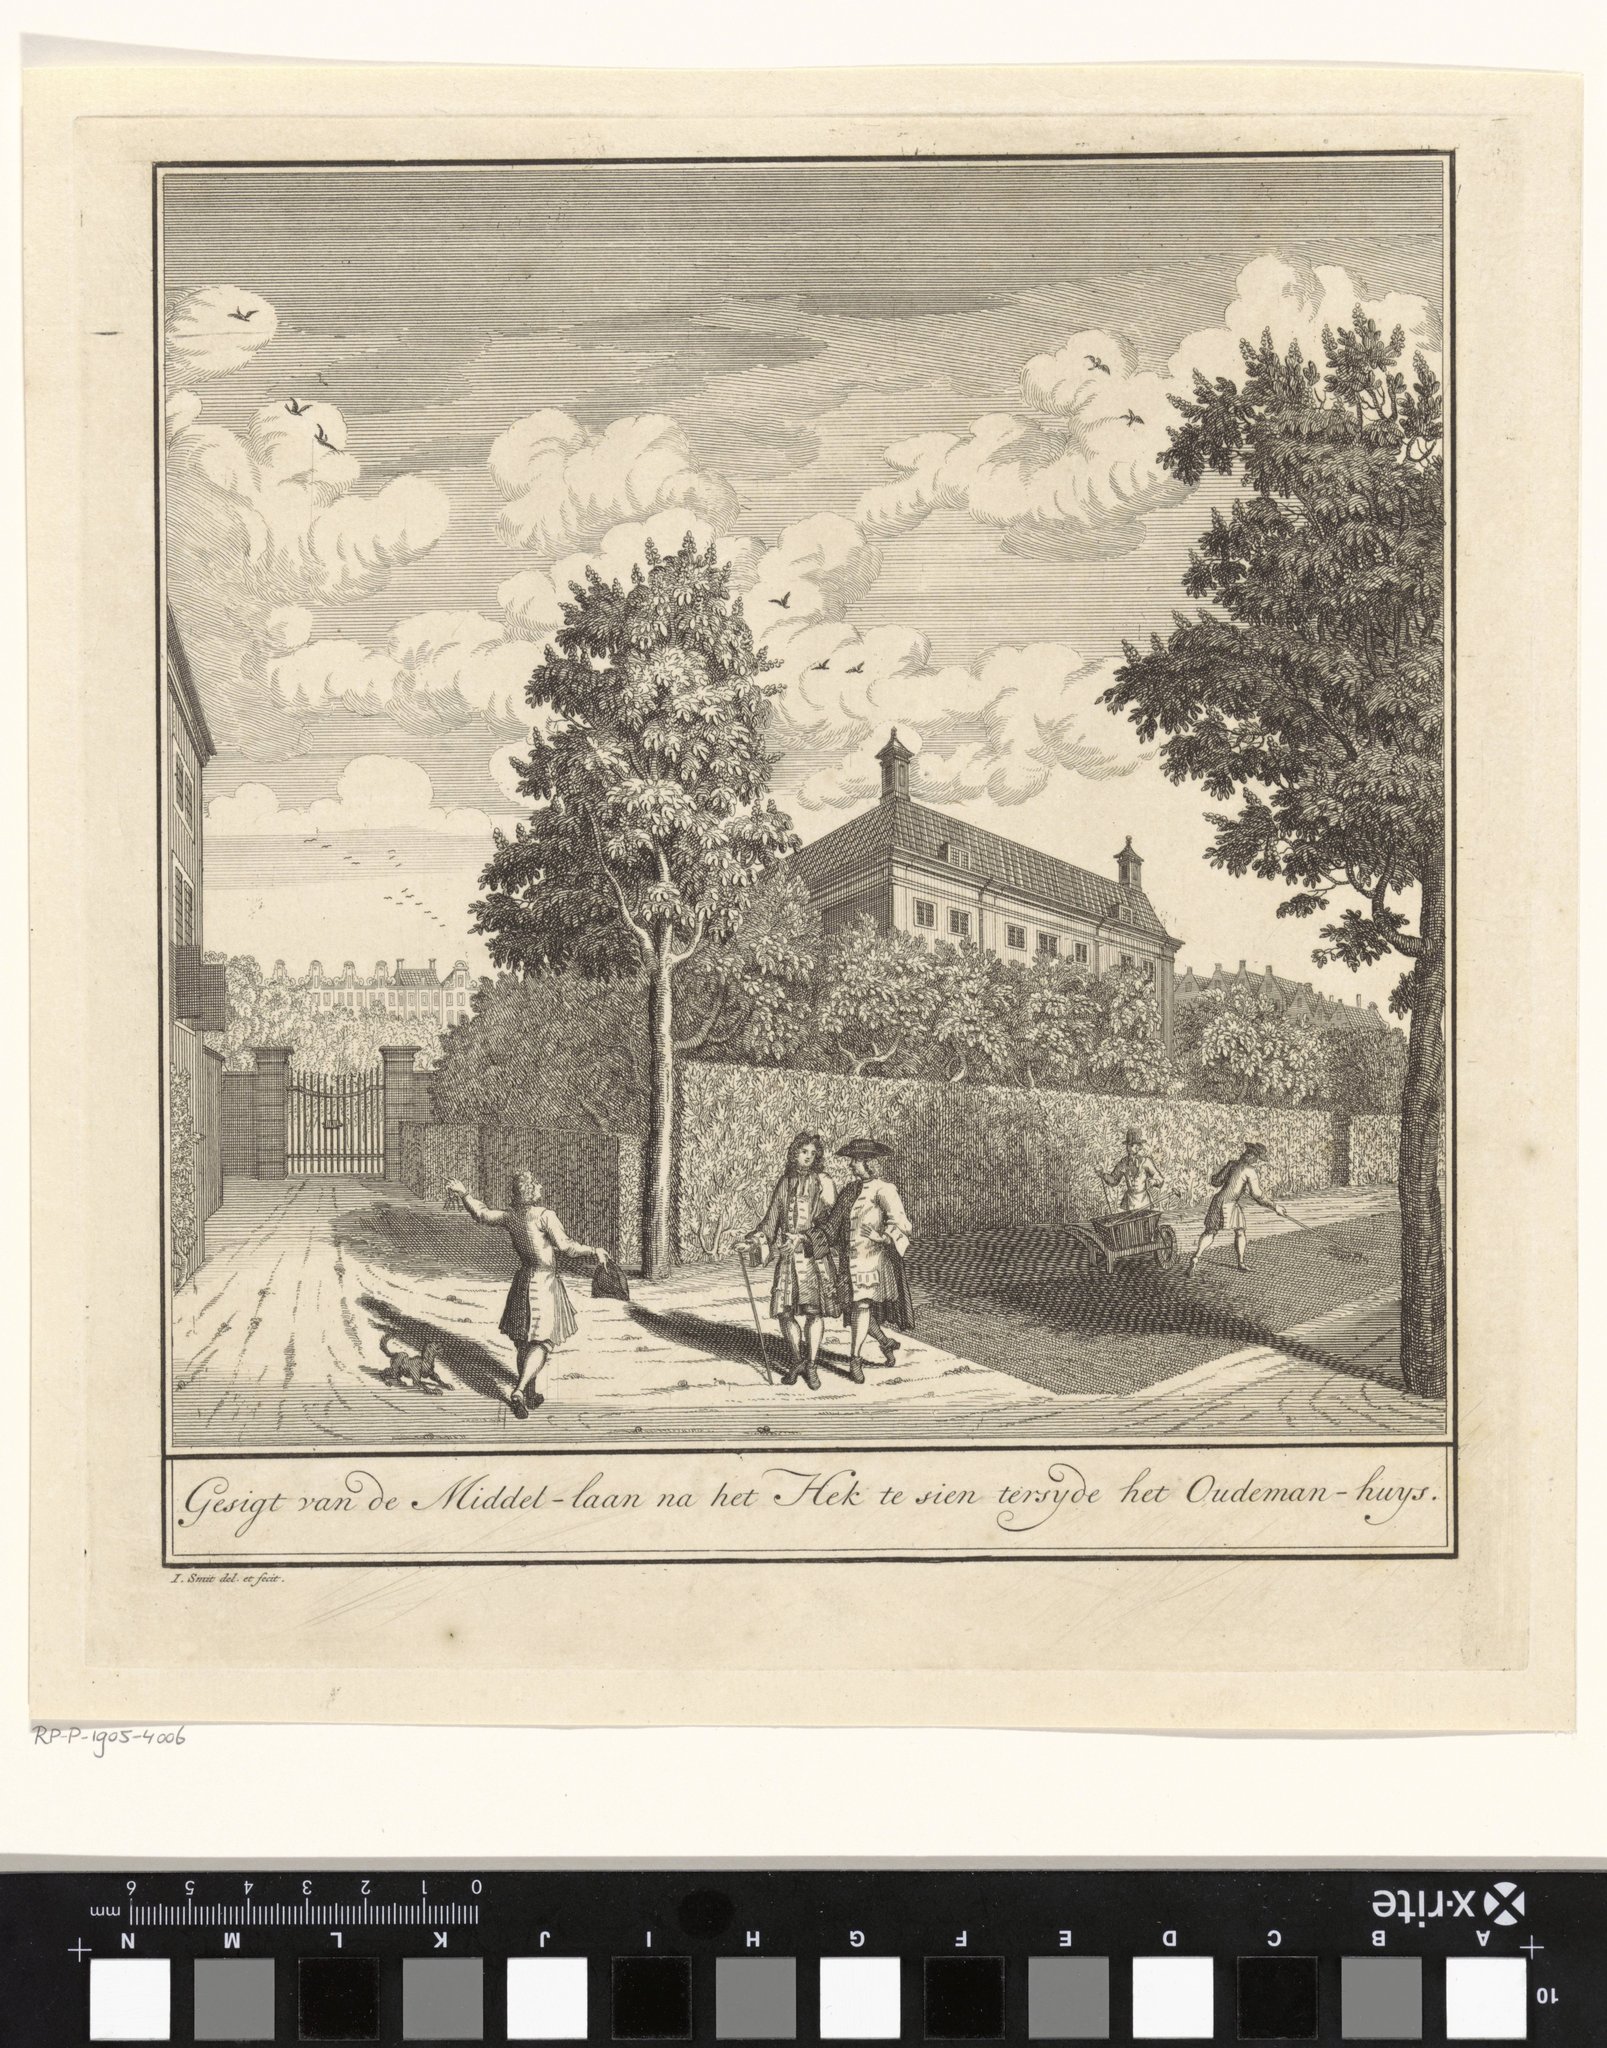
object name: print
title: Gezicht op de achterkant en een deel van de tuin van het Corvershof te Amsterdam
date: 1723-1748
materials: paper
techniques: engraving, etching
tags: alms-house (dutch: 'hofje'), public welfare, key, french or architectonic garden; formal garden, gate, entrance, gardening, dog, old-people's home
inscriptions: collector's mark: Lugt 2228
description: Gezicht op de achterkant en een deel van de tuin van het Corvershof aan de Nieuwe Herengracht te Amsterdam. Links op de achtergrond het hek naast het Diaconie Oude Vrouwen- en Mannenhuis aan de Nieuwe Herengracht. Op de voorgrond staat en man met een sleutelbos in zijn hand. Links van hem een hondje, rechts van hem twee wandelende mannen. In het midden van de laan rechts zijn twee tuinmannen aan het werk. Onderdeel van een serie prenten van het in 1723 in gebruik genomen Corvershof, bestemd voor oudere echtparen van Nederduits Gereformeerde (later Hervormde) huize.